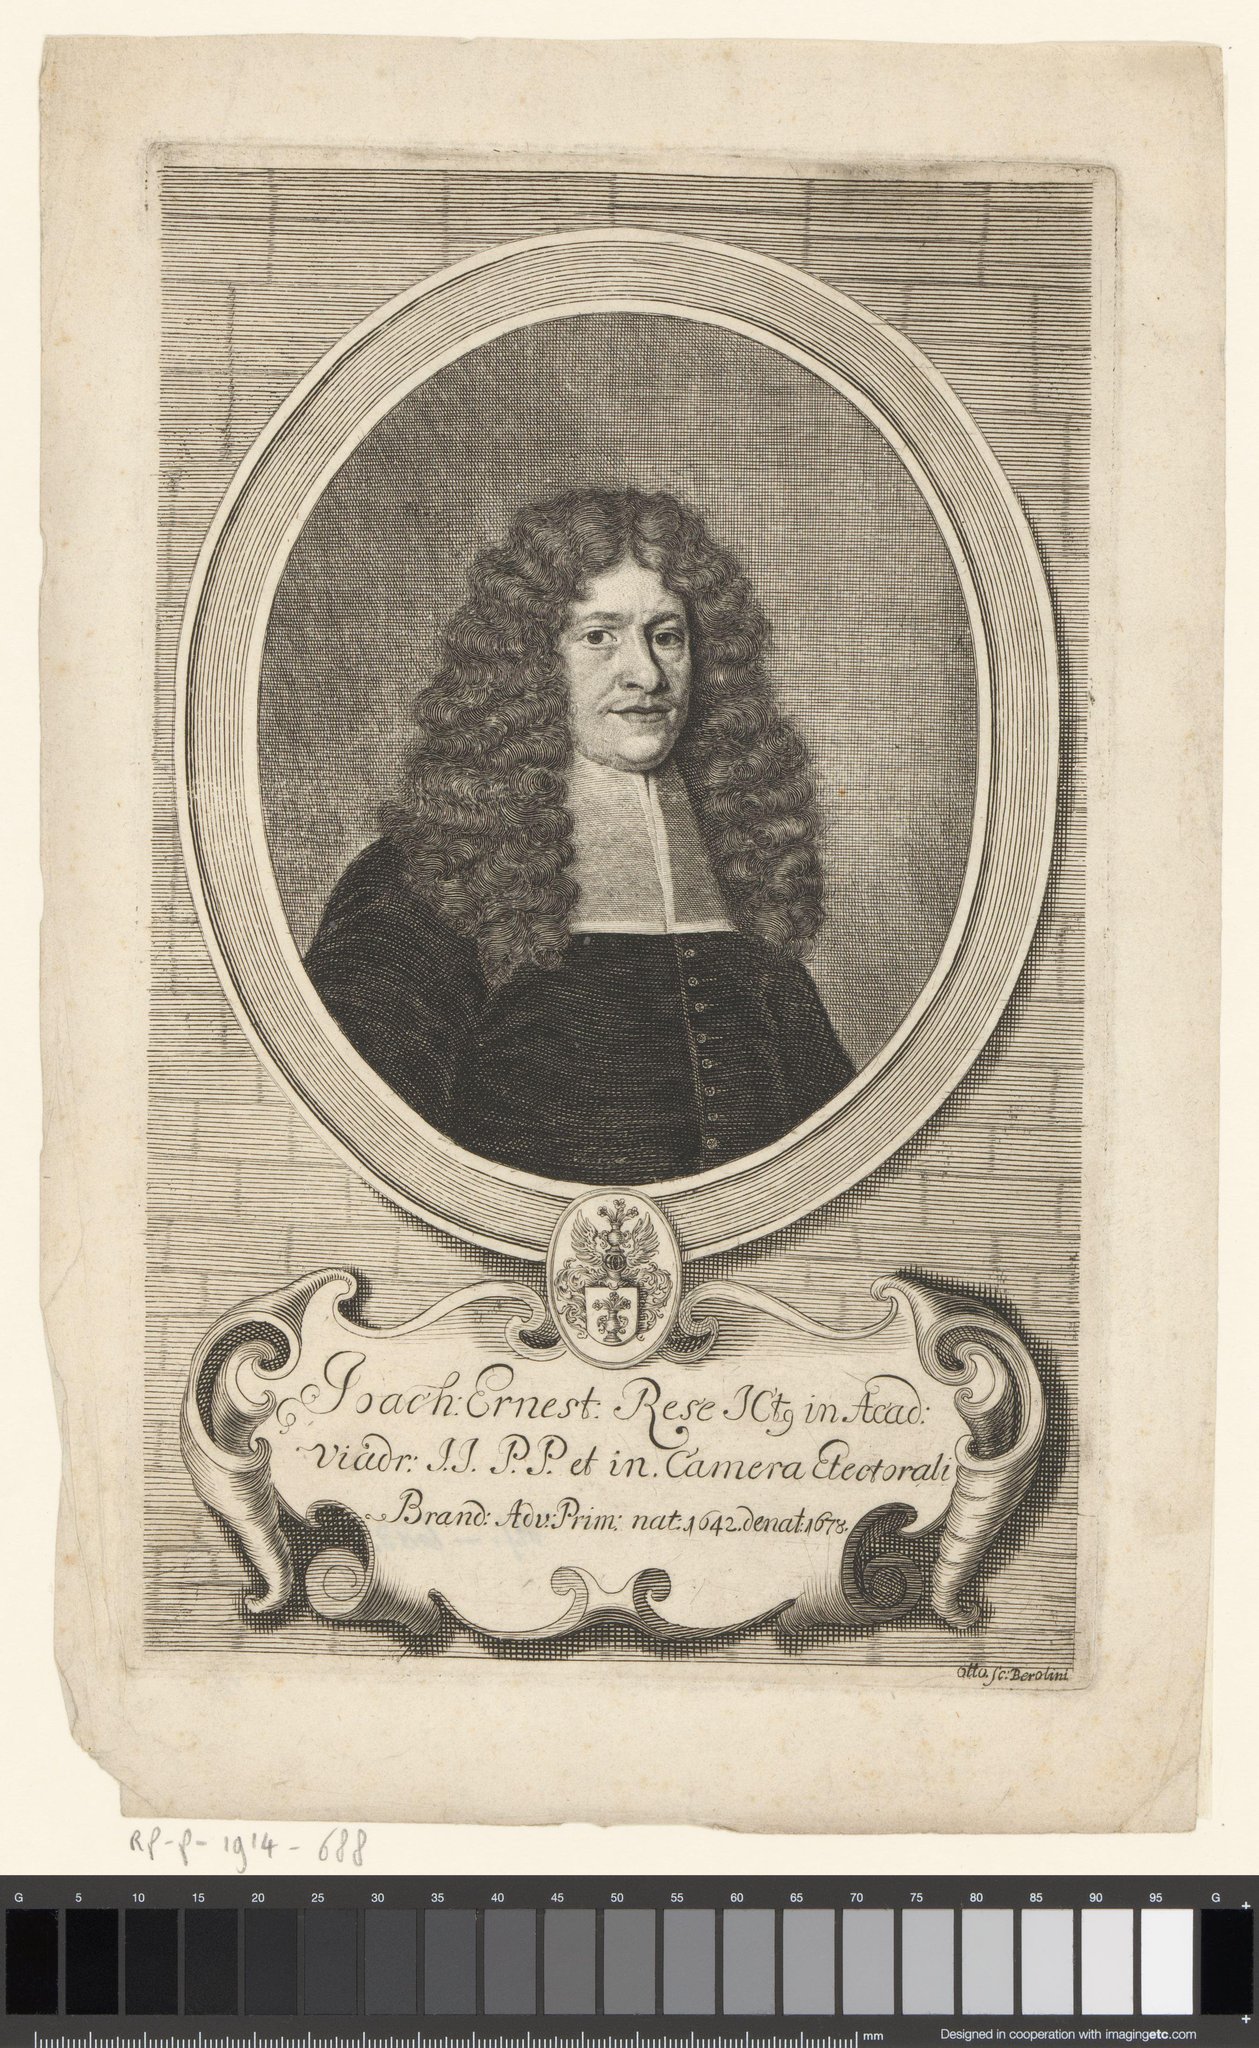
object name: print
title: Portret van Joachim Ernst Rese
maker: heinrich jakob otto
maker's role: print maker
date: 1657-1749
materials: paper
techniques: engraving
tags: historical persons, armorial bearing, heraldry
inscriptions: collector's mark: Lugt 2228